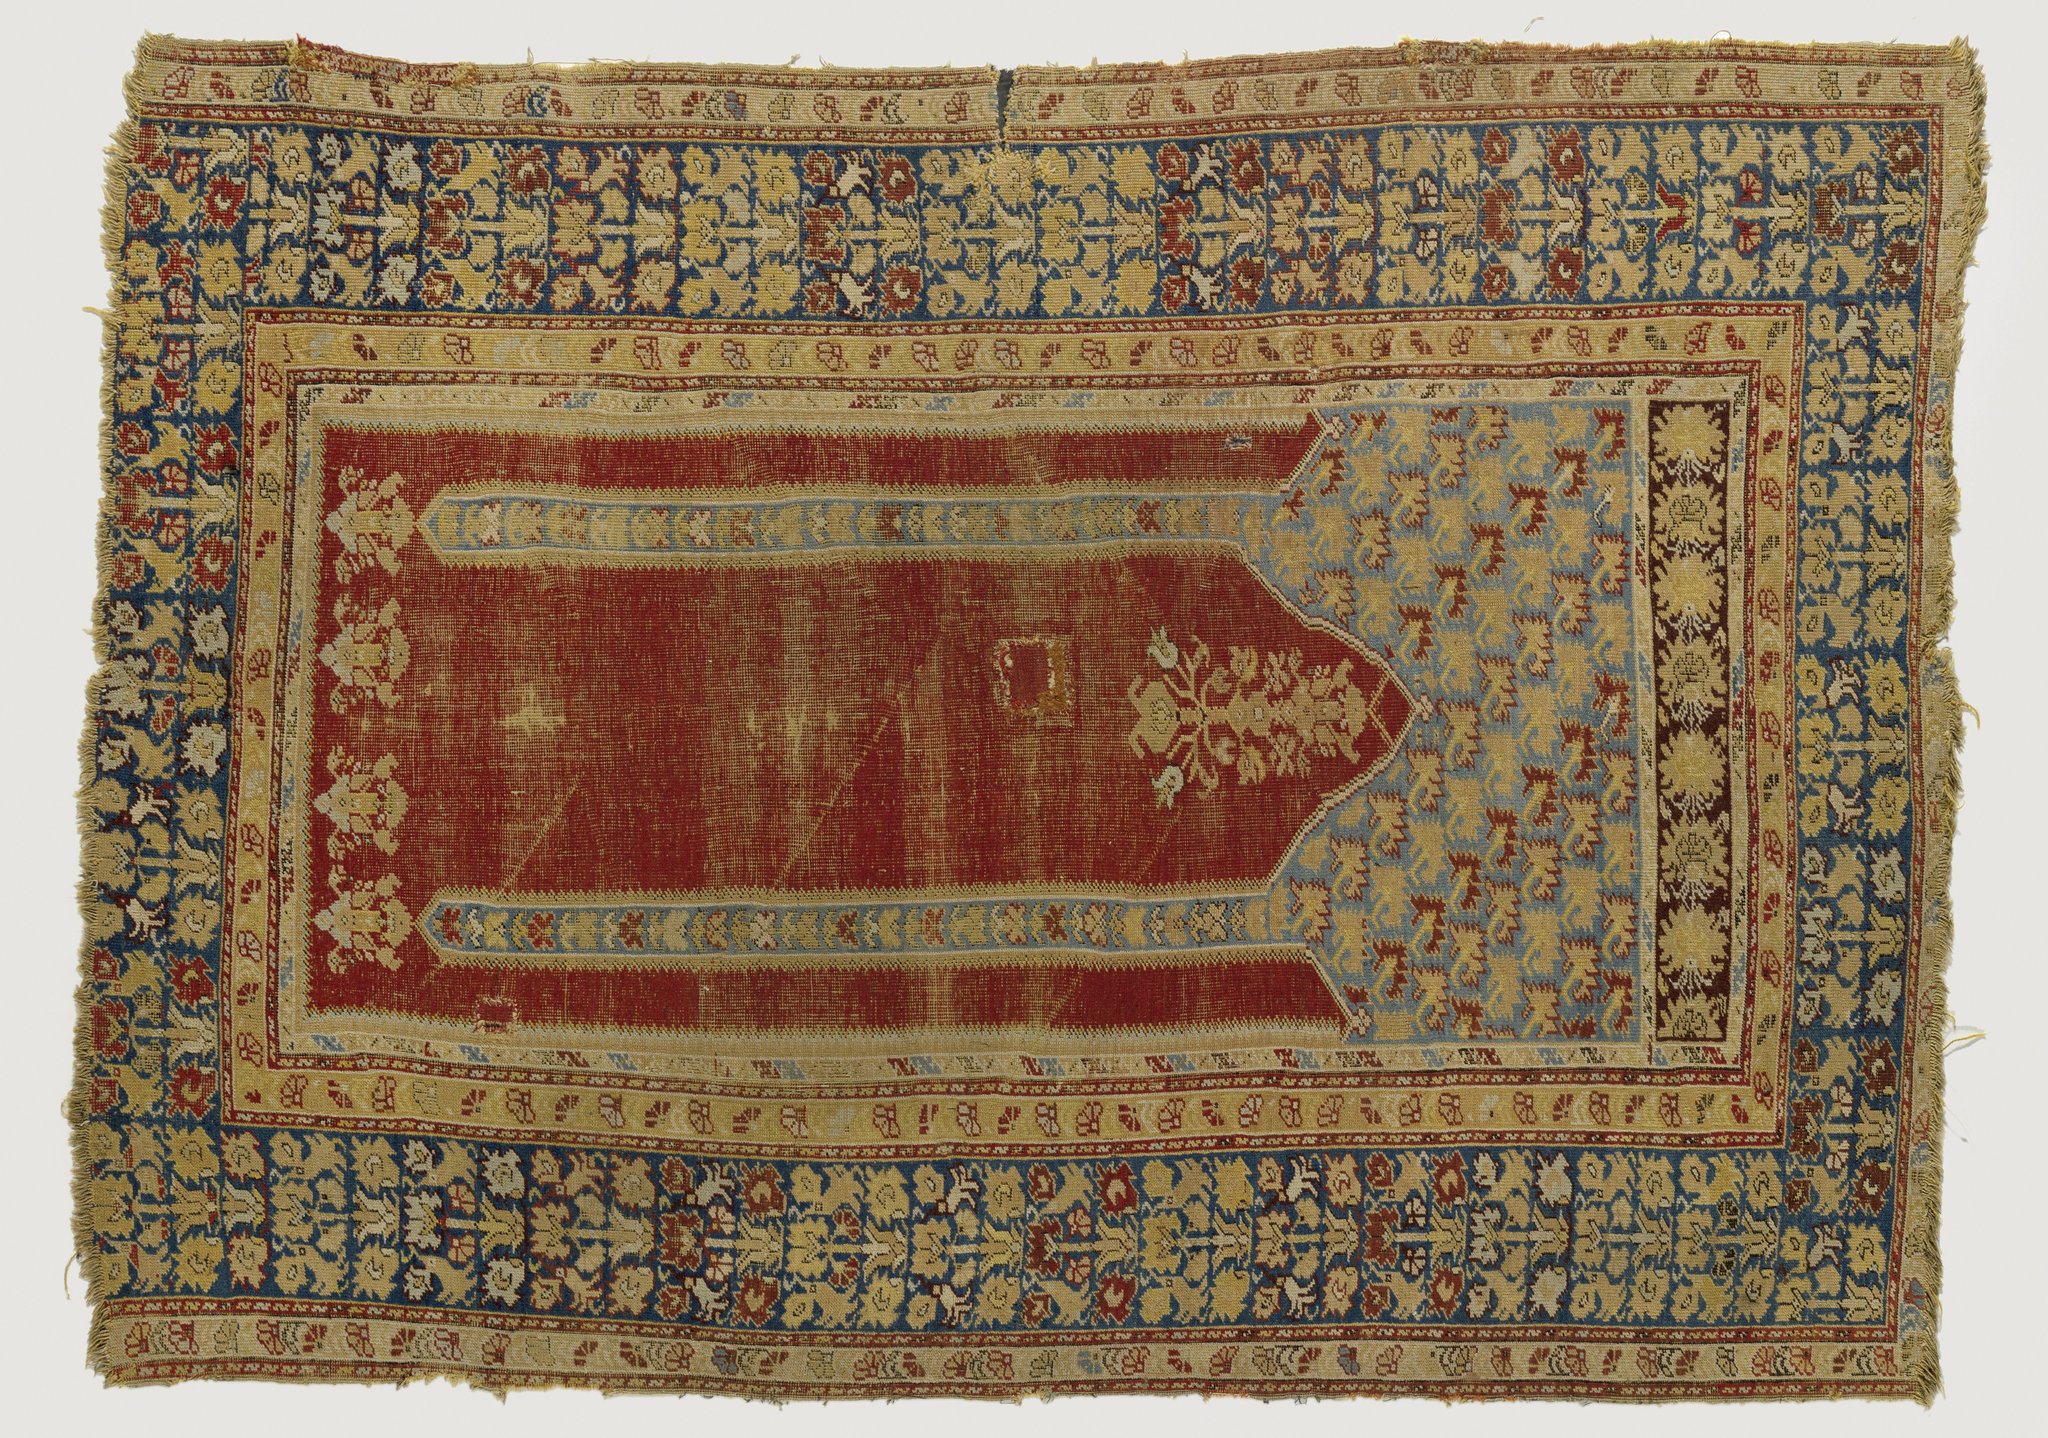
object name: oriental rug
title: Oosters tapijt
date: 1800-1900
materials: wool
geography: kula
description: Oosters tapijt, bidkleed, van geknoopte wol, versierd met een terra-cotta mihrab, met een rechthoekige top, gestut door twee zuilen. In de top hangt een gestileerde lamp. De zwikken zijn gevuld met plataanbladeren. Rondom drie randen en vier zomen.